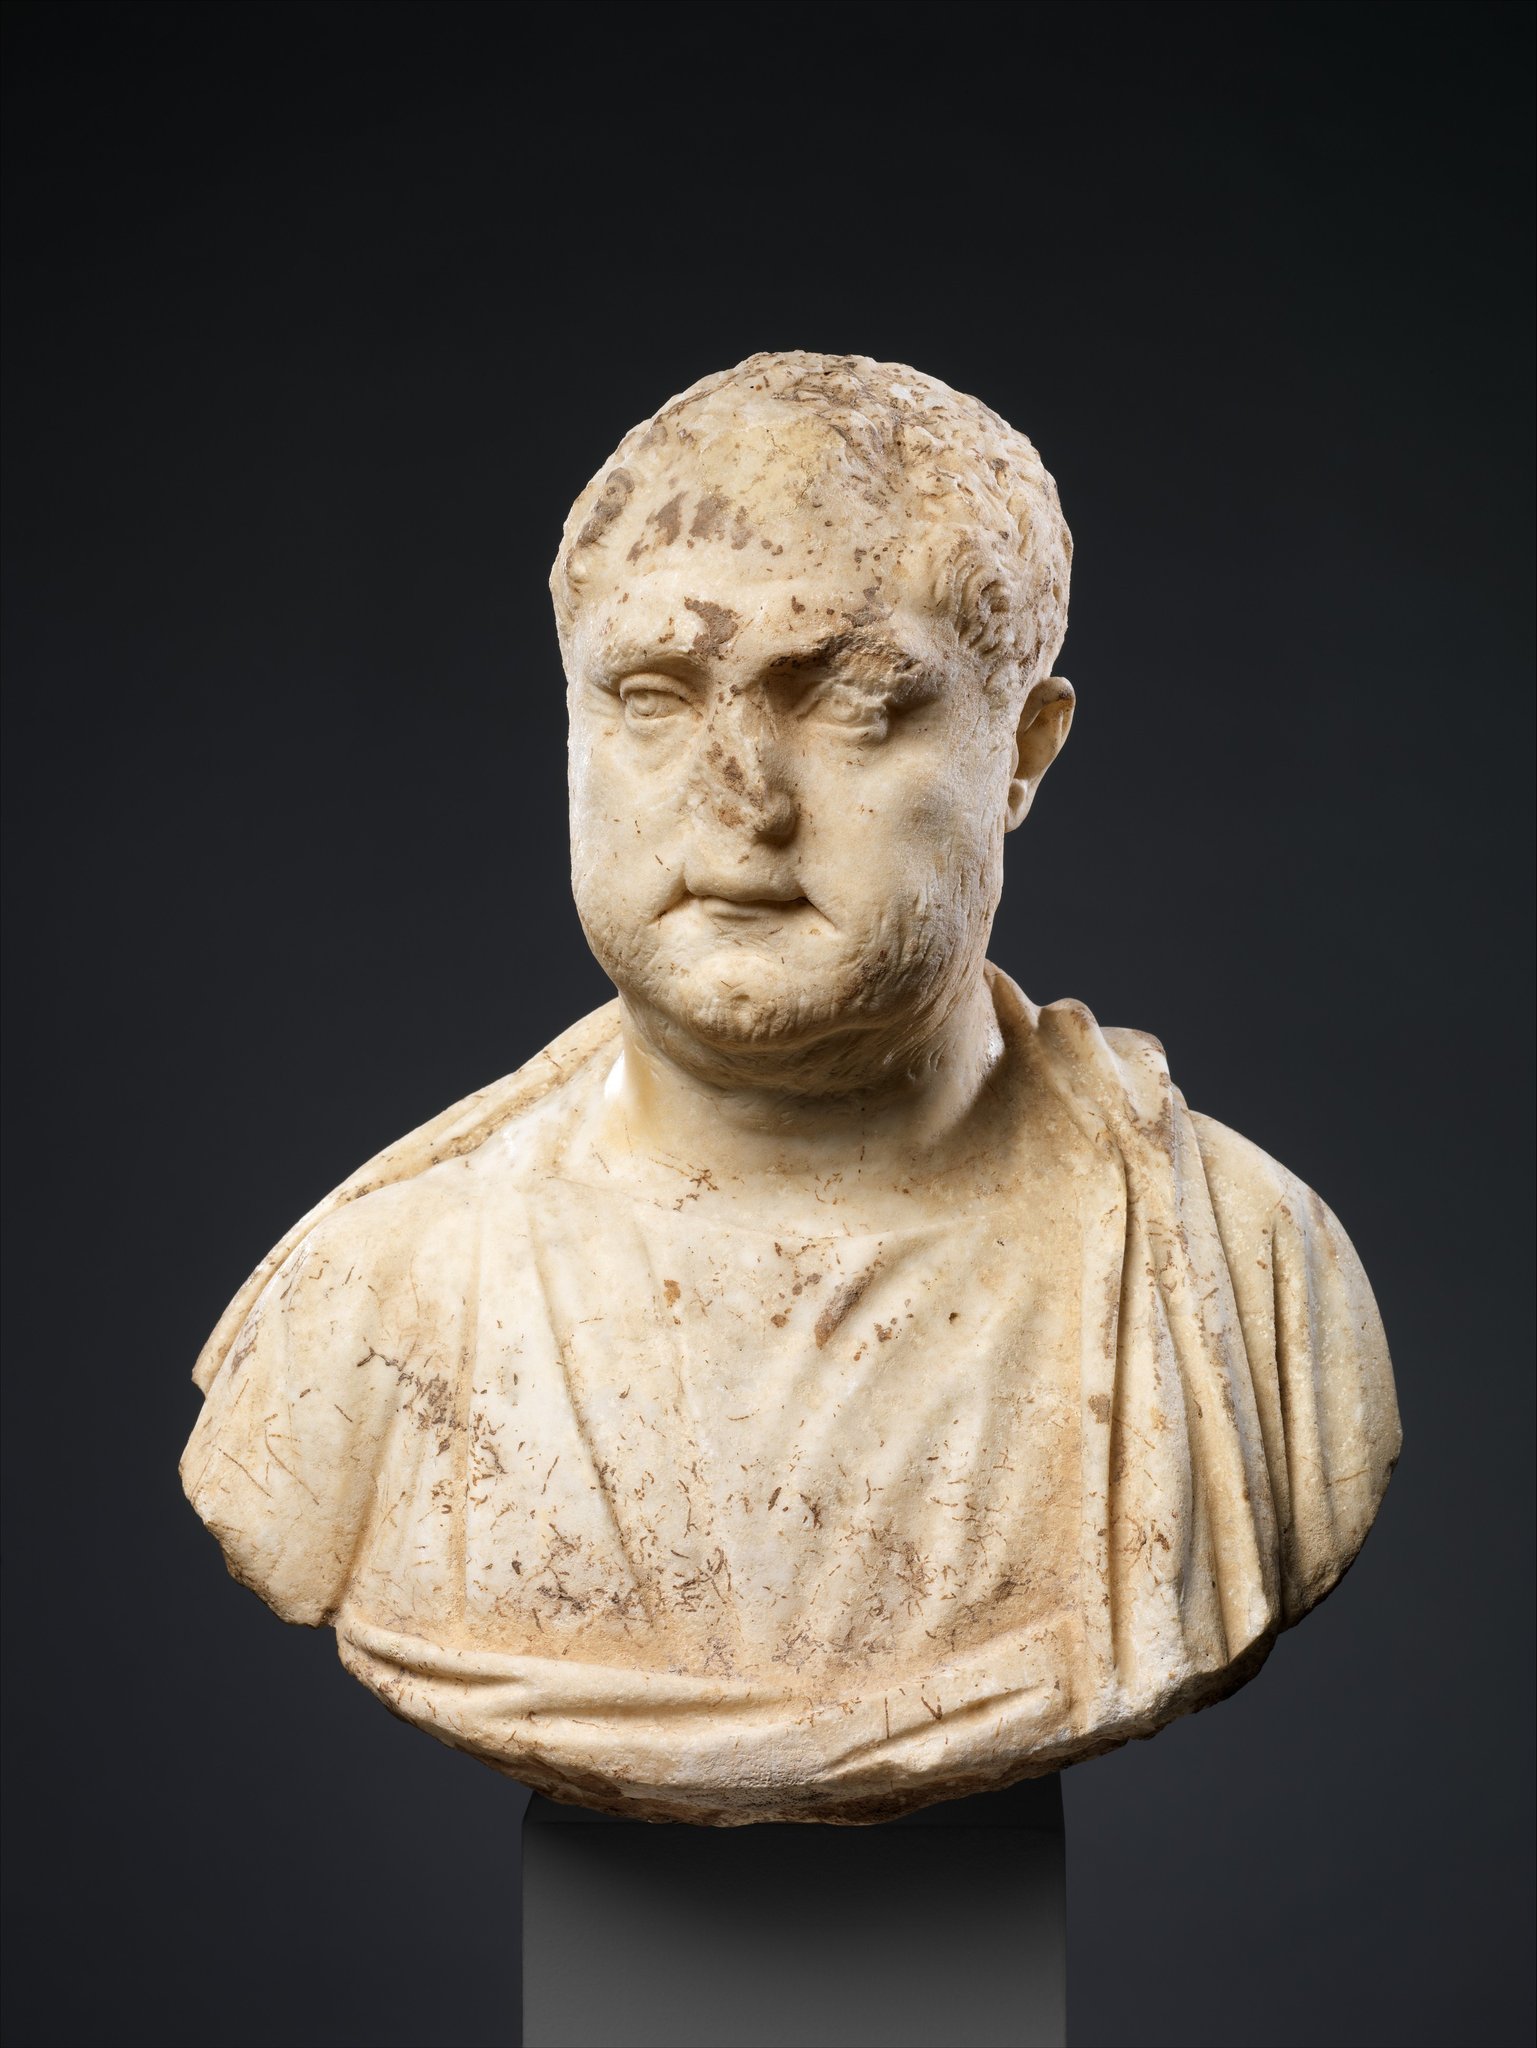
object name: portrait bust of a man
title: Marble portrait bust of a man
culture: roman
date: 234-266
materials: marble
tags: men,portraits